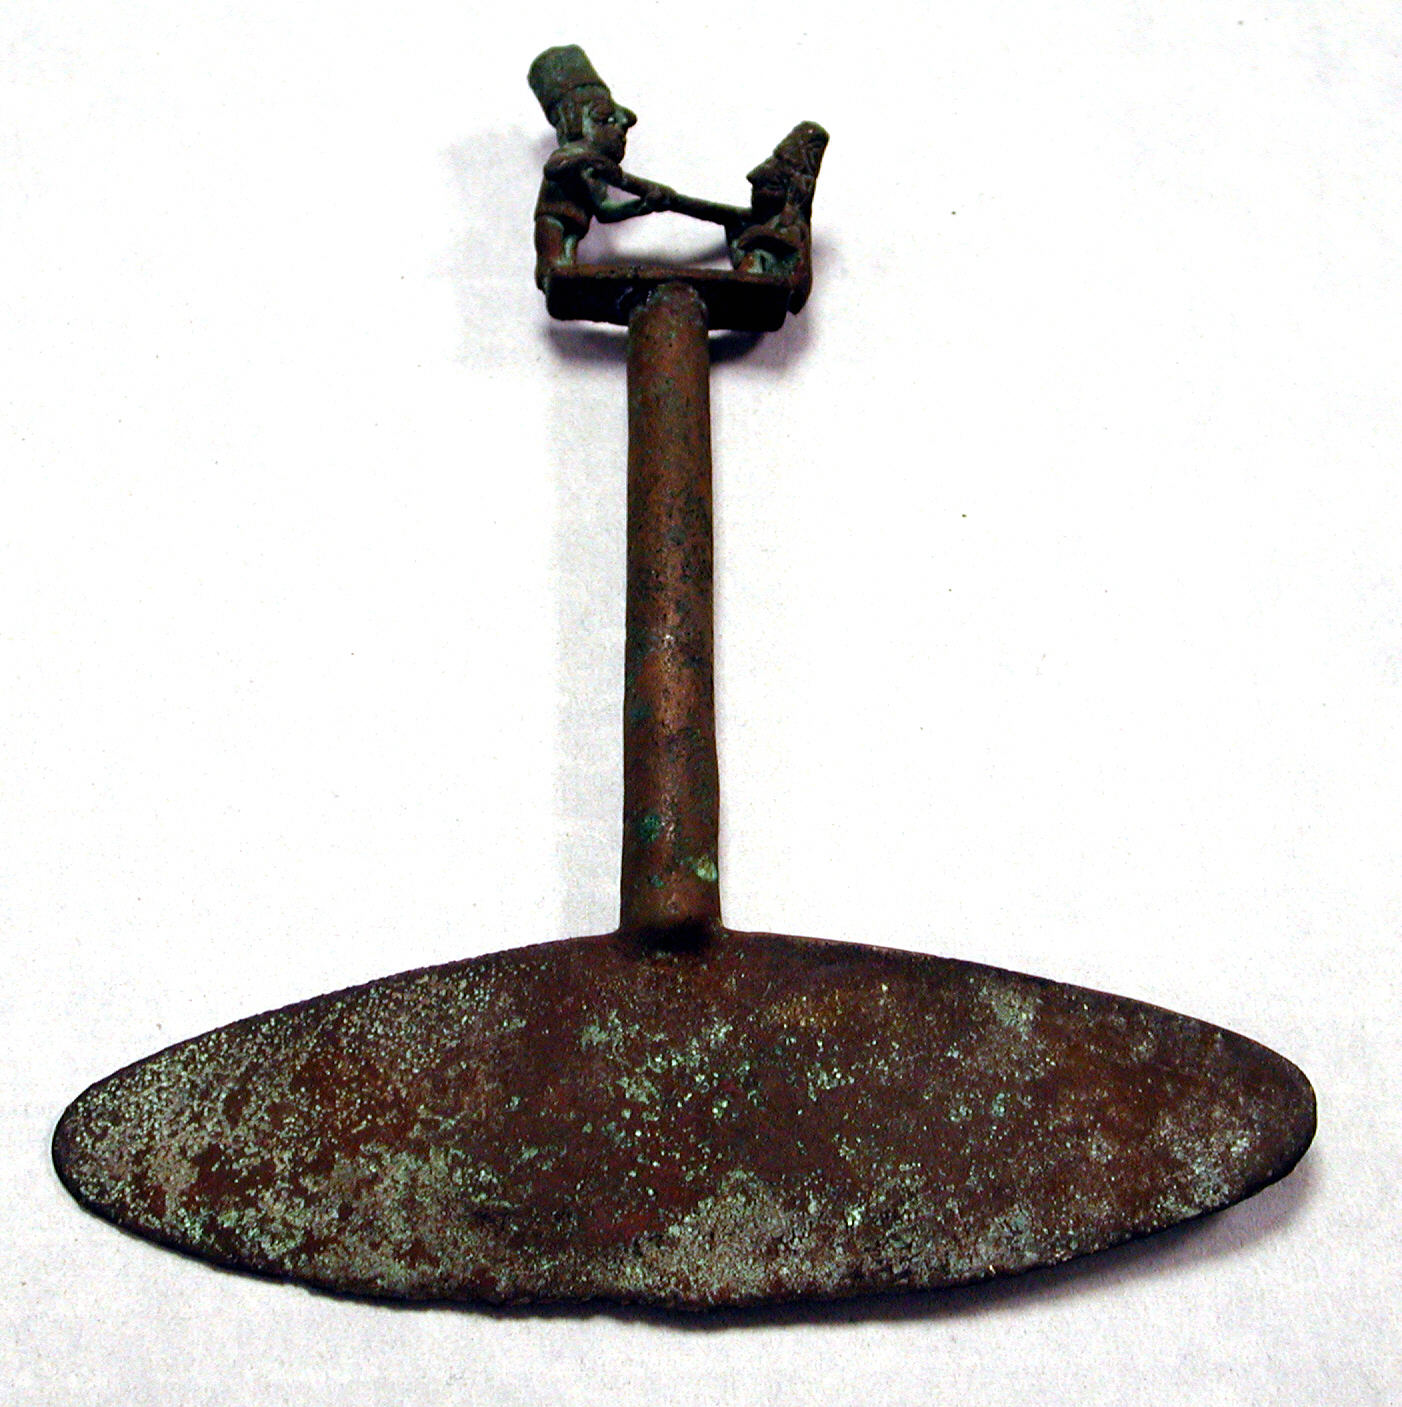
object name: knife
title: Ceremonial Knife (Tumi)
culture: inca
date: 1401-1600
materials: copper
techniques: casting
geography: peru